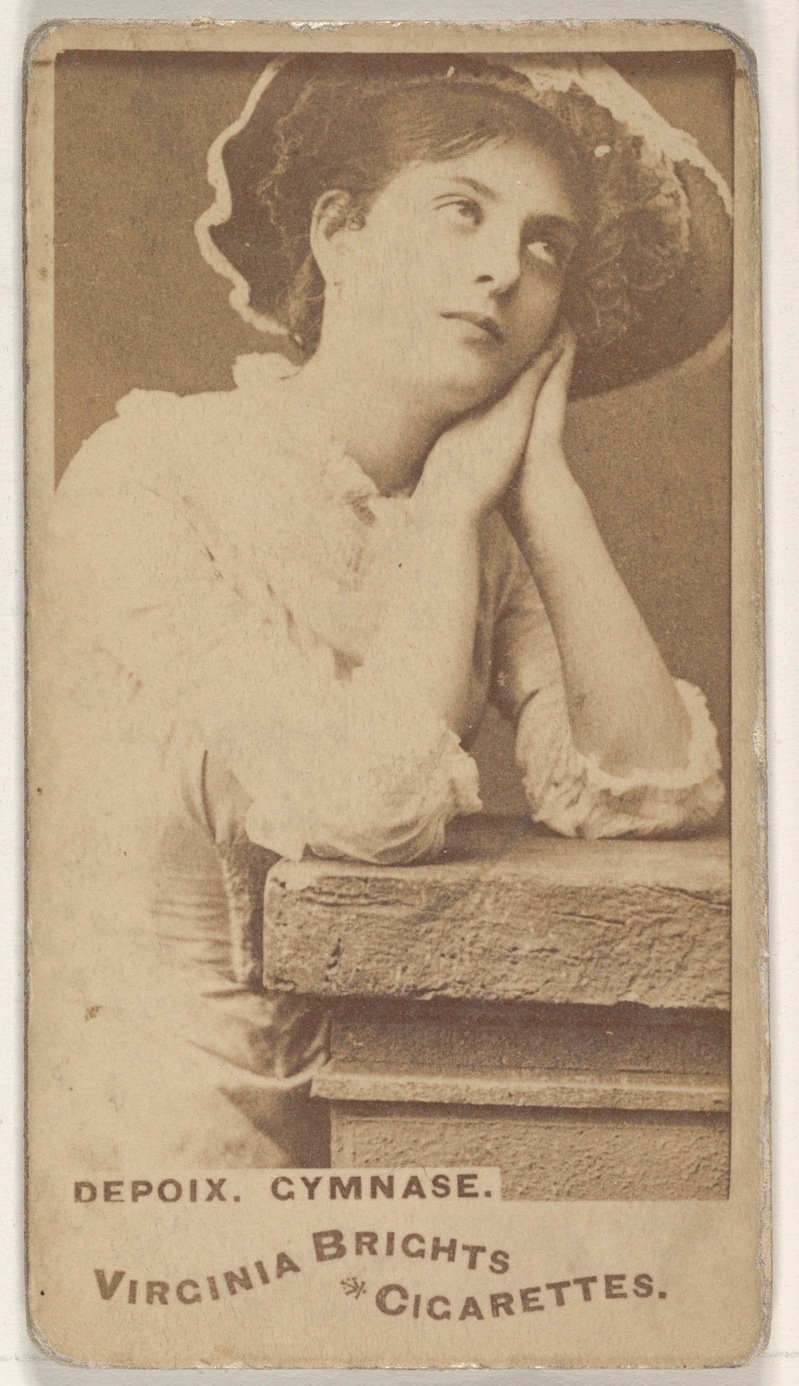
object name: photograph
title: Depoix, Gymnase, from the Actors and Actresses series (N45, Type 1) for Virginia Brights Cigarettes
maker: allen & ginter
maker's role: publisher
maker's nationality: american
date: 1888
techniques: albumen silver print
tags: portraits,women,actresses